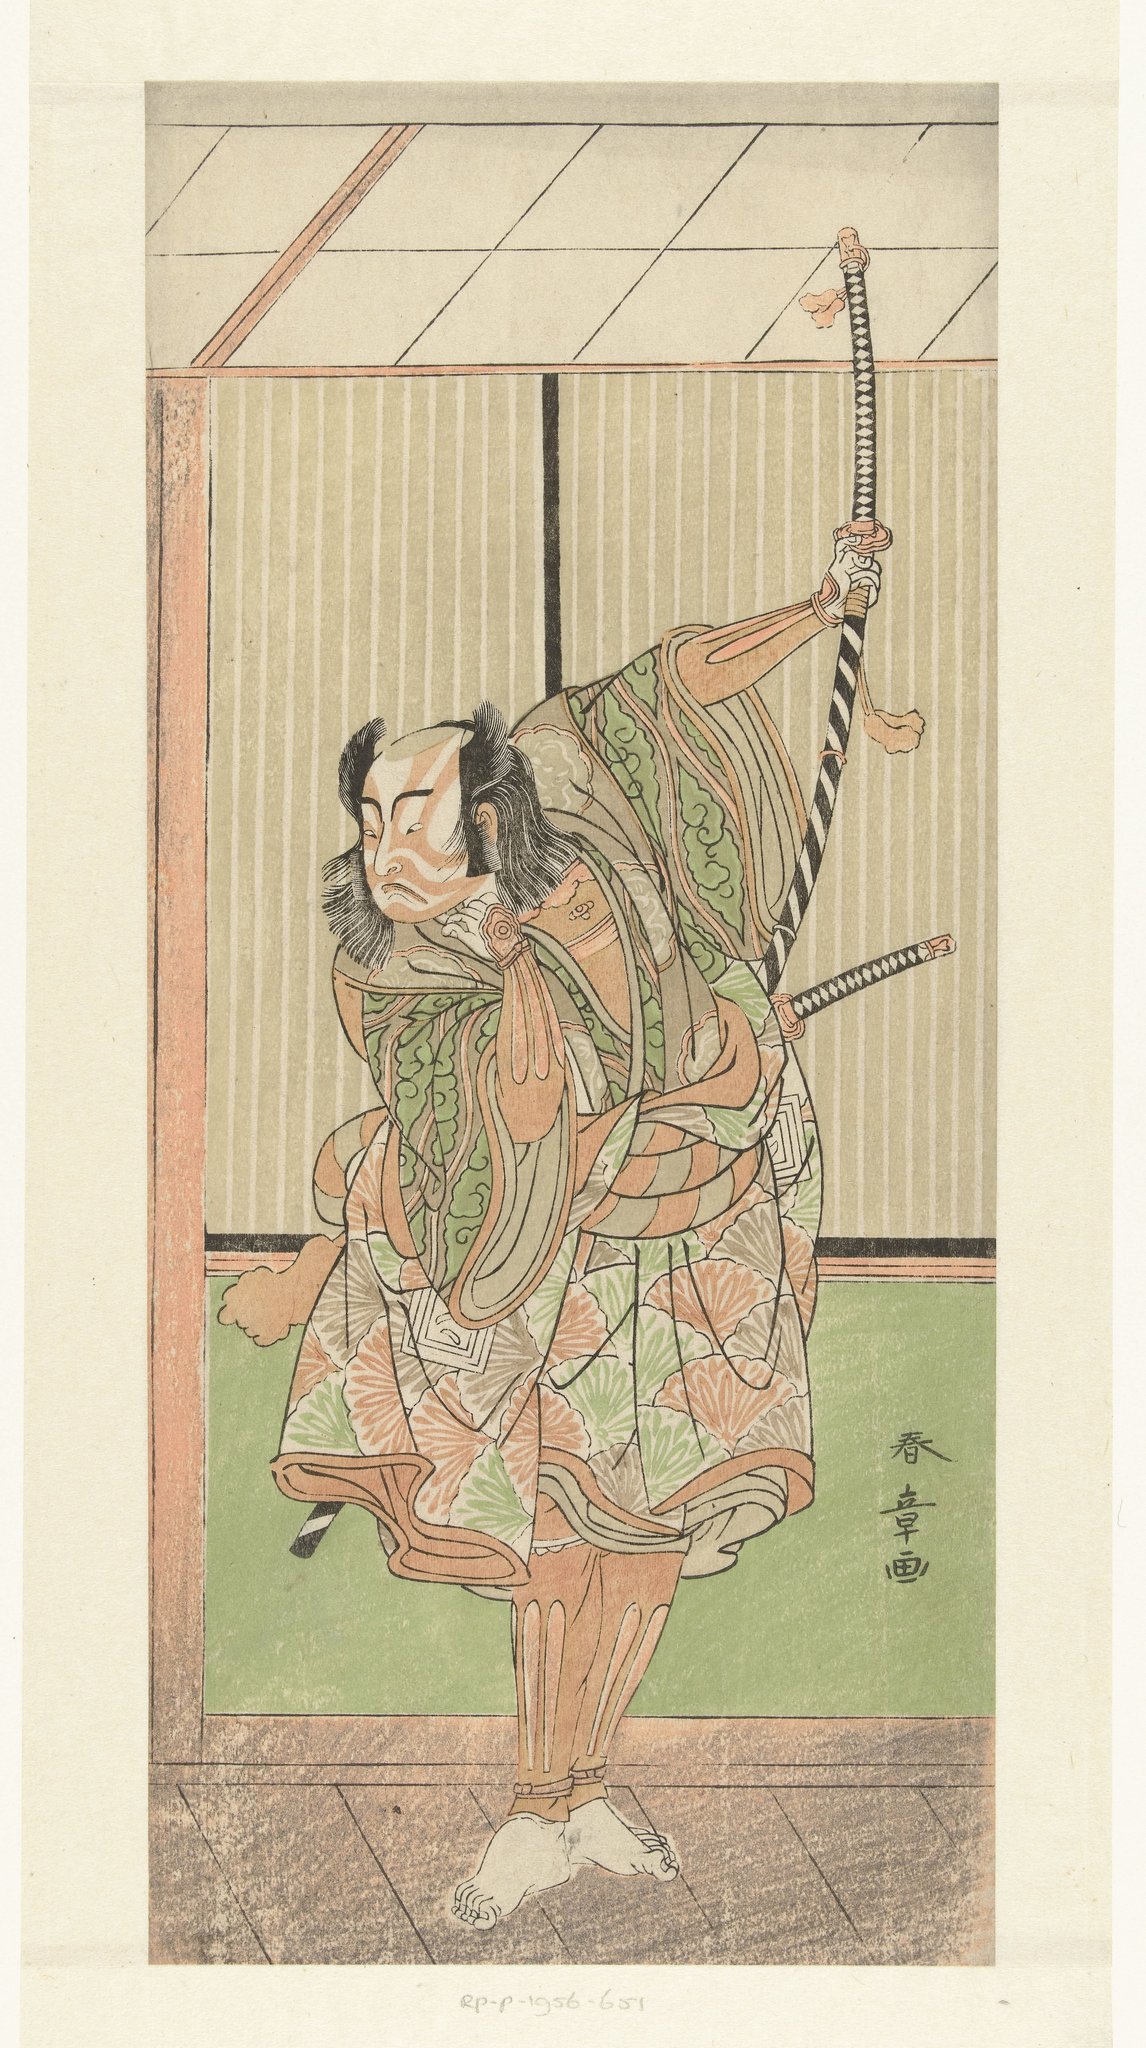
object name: print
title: Acteur Ichikawa Yaozo met lang zwaard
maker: katsukawa shunsho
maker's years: 1726-1792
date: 1771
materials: paper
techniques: woodcut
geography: japan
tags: hacking and thrusting weapons: sword, portrait of actor, actress, loggia, verandah, porch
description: Acteur Ichikawa Yaozo, in kleding met waaierpatroon, lang zwaard in linker hand, staand voor tatami kamer, op houten veranda, onder afdakje.